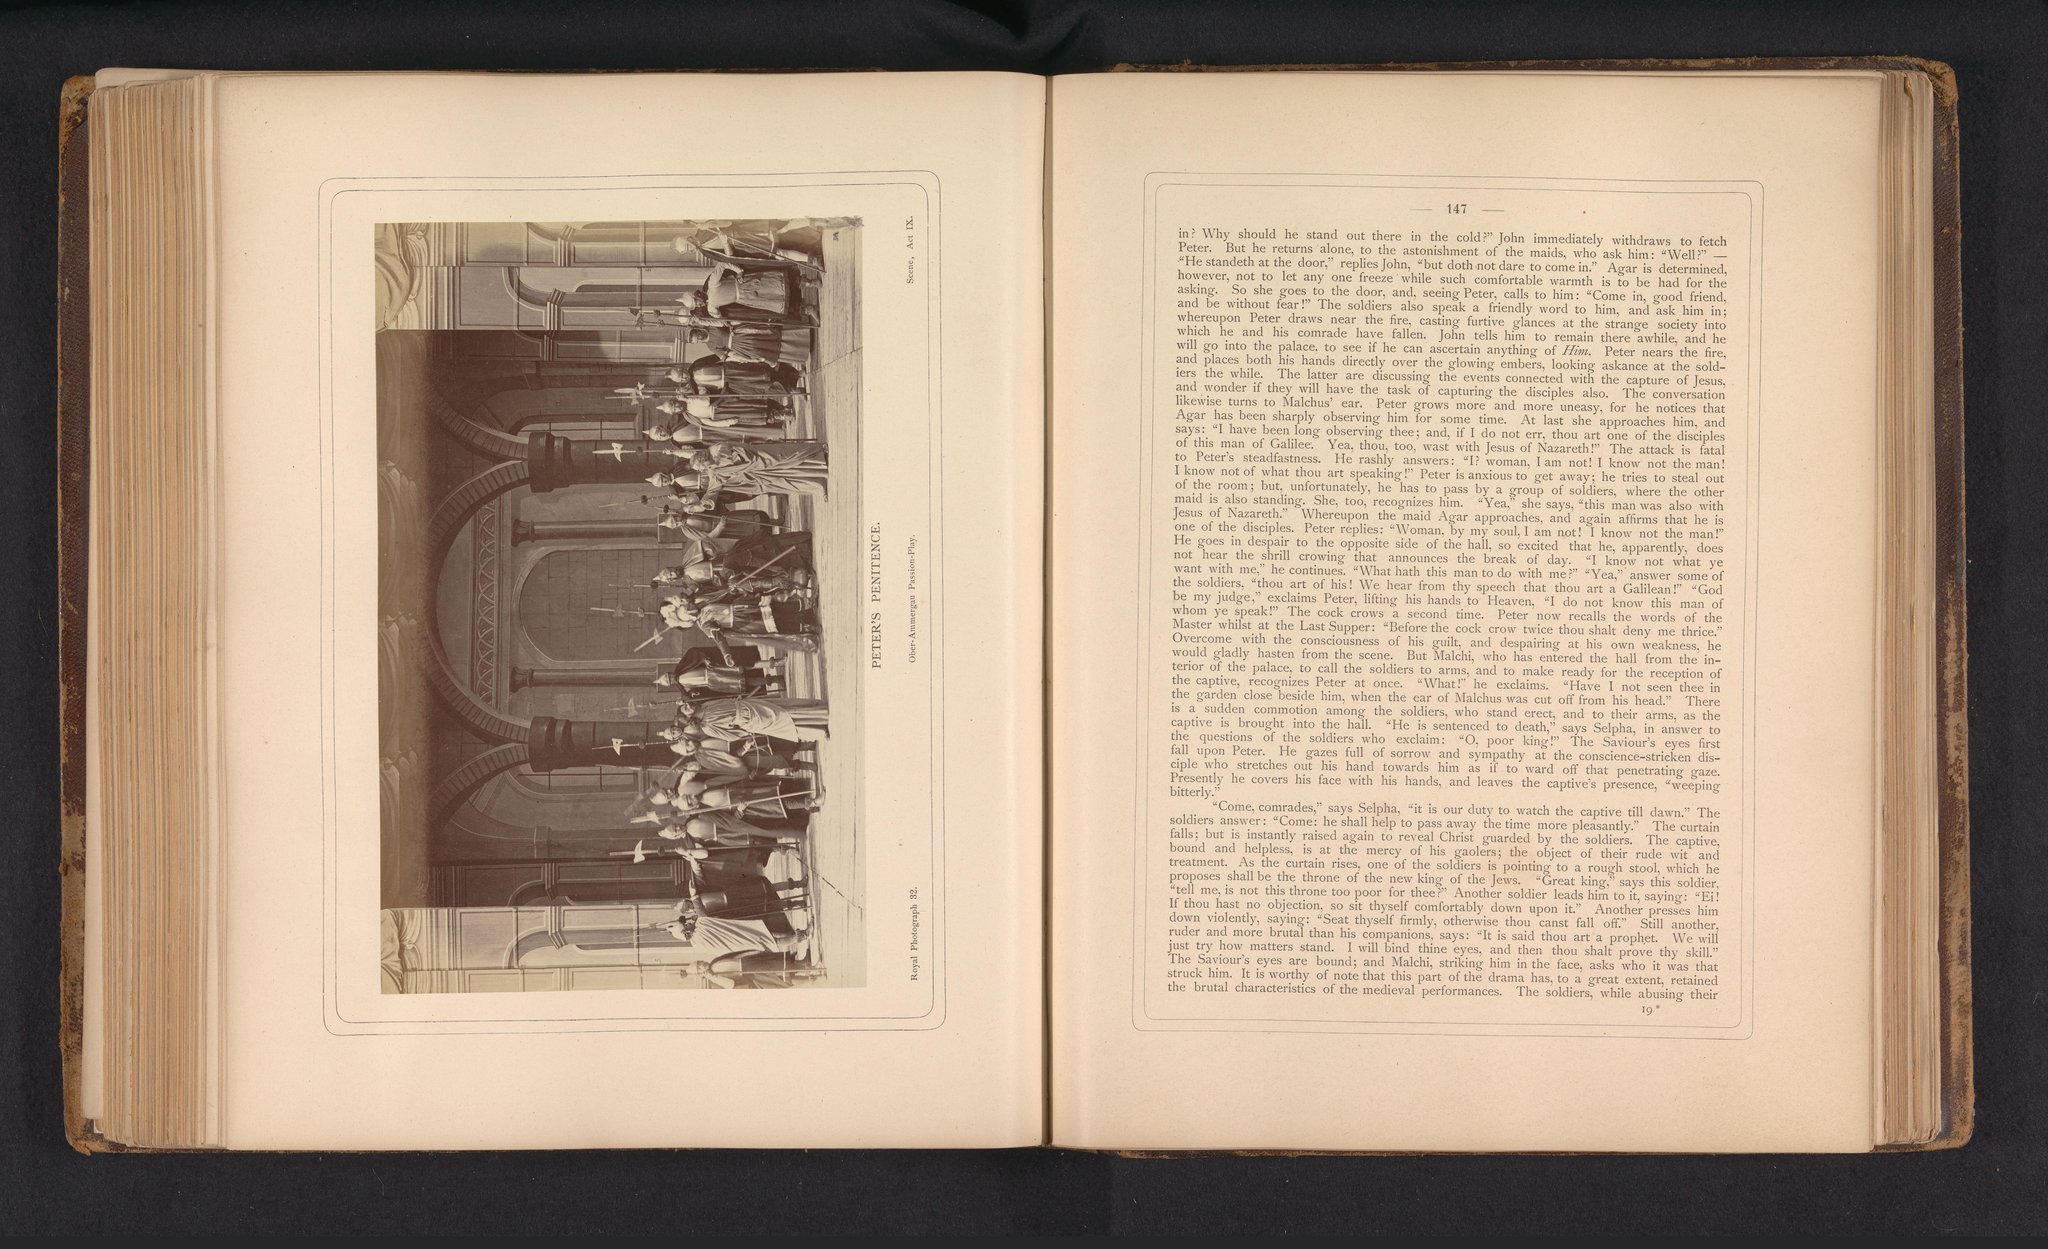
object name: photograph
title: Peter's penitence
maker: joseph albert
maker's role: printer, publisher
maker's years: 1825-1886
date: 1868-1873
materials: photographic support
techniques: albumen print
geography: oberammergau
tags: group of actors, troupe; actors on the stage, repentance of peter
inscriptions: number: ‘Royal Photograph 32.’